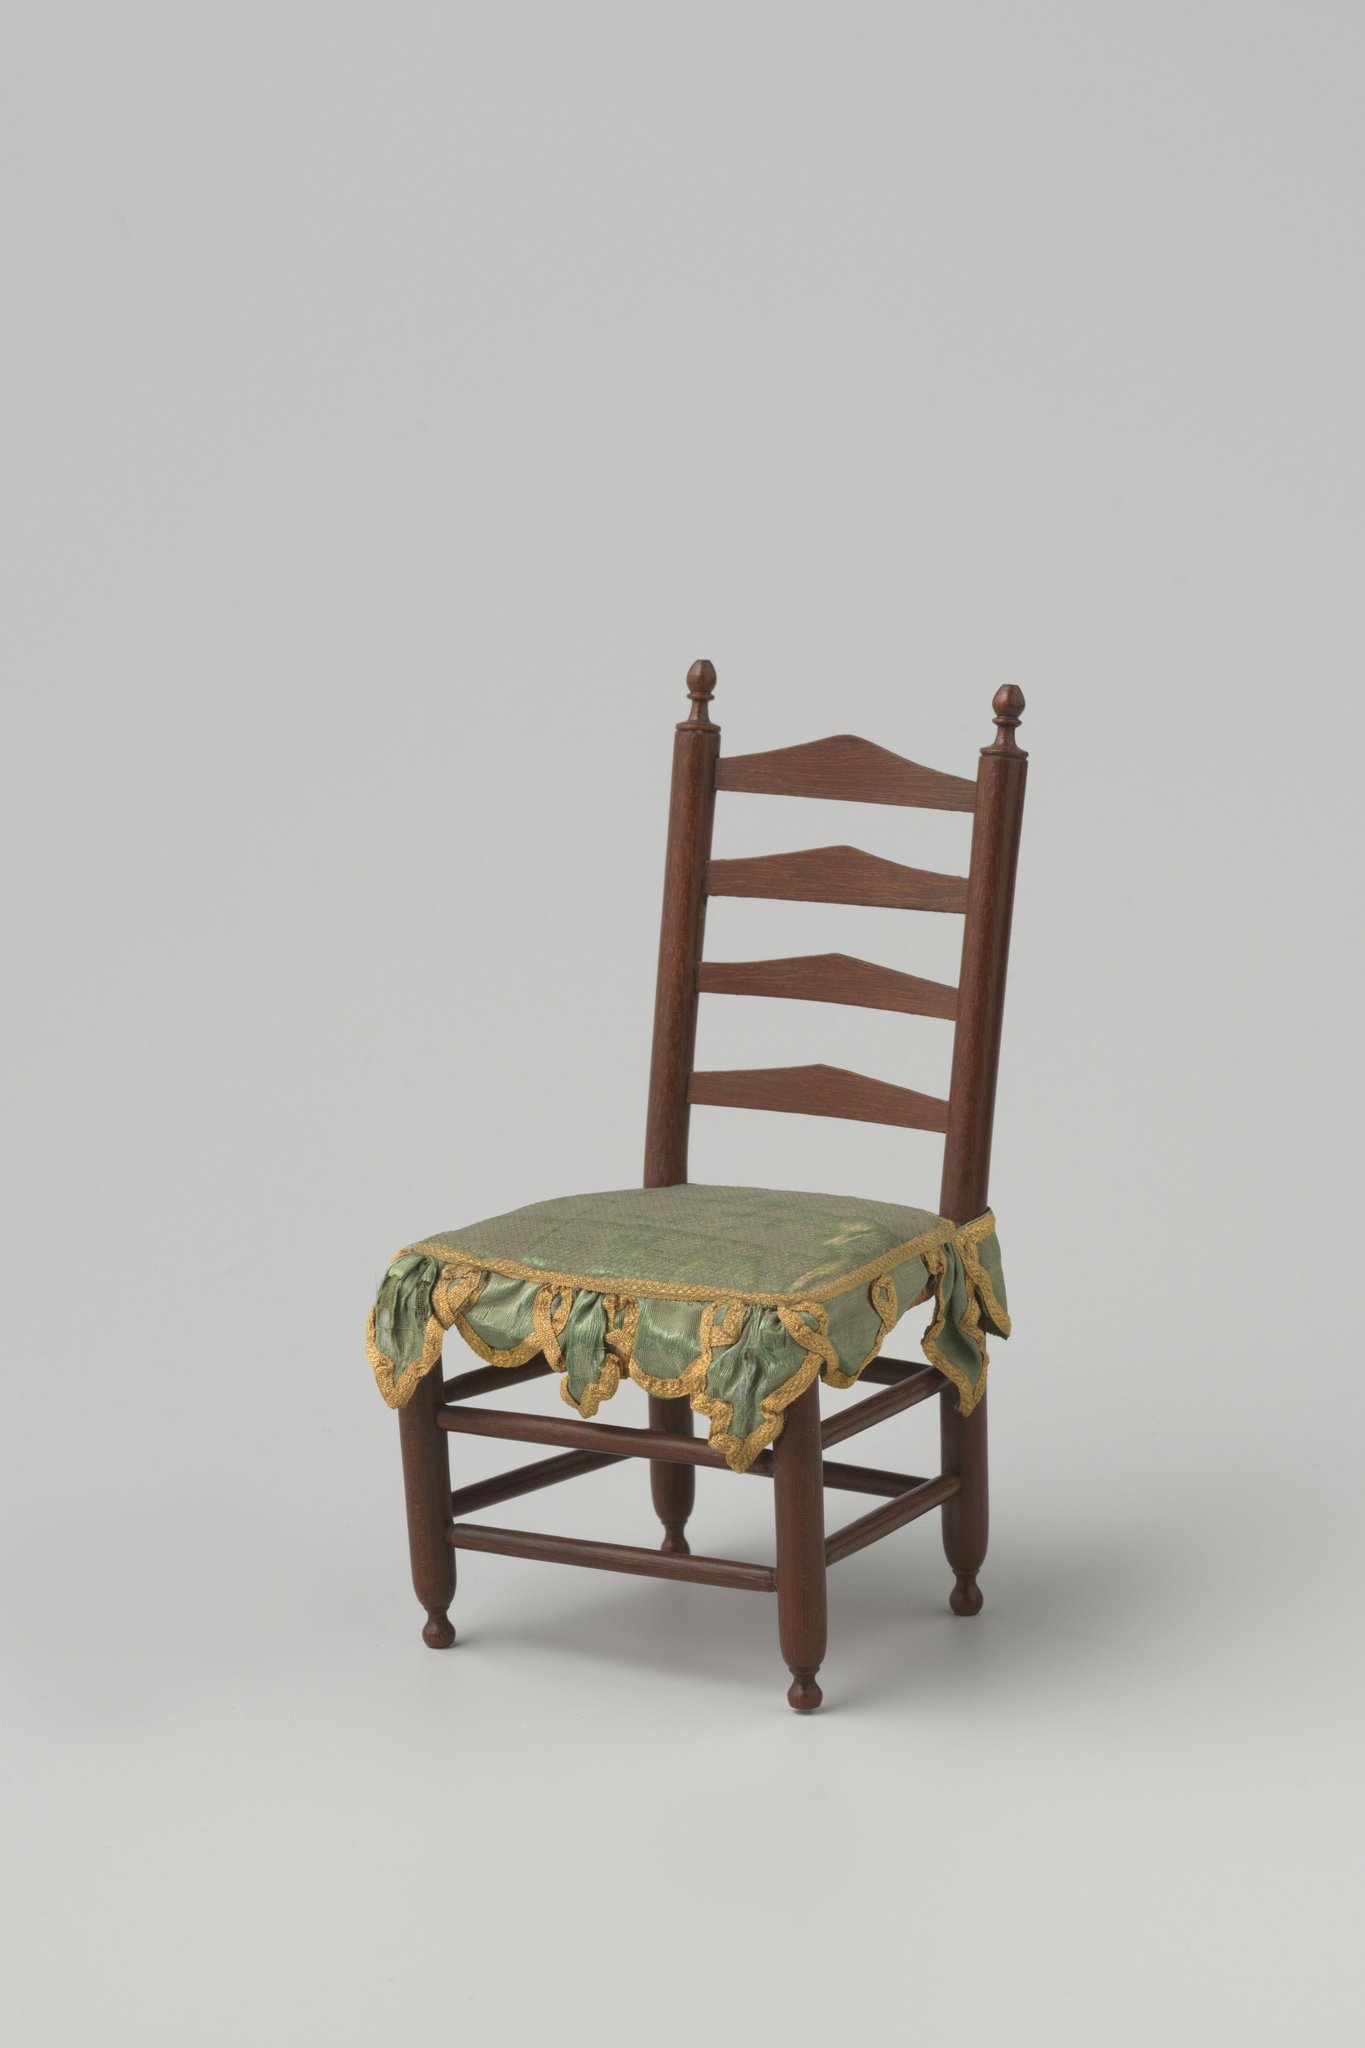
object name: chair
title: Knopstoel vervaardigd van hardhout, met gladde gedraaide stijlen en dwarsregels, voorpoten en achterstijlen eindigend in fijn gedraaide knoppen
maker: Anonymous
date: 1690-1710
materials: wood, silk, fiber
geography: amsterdam